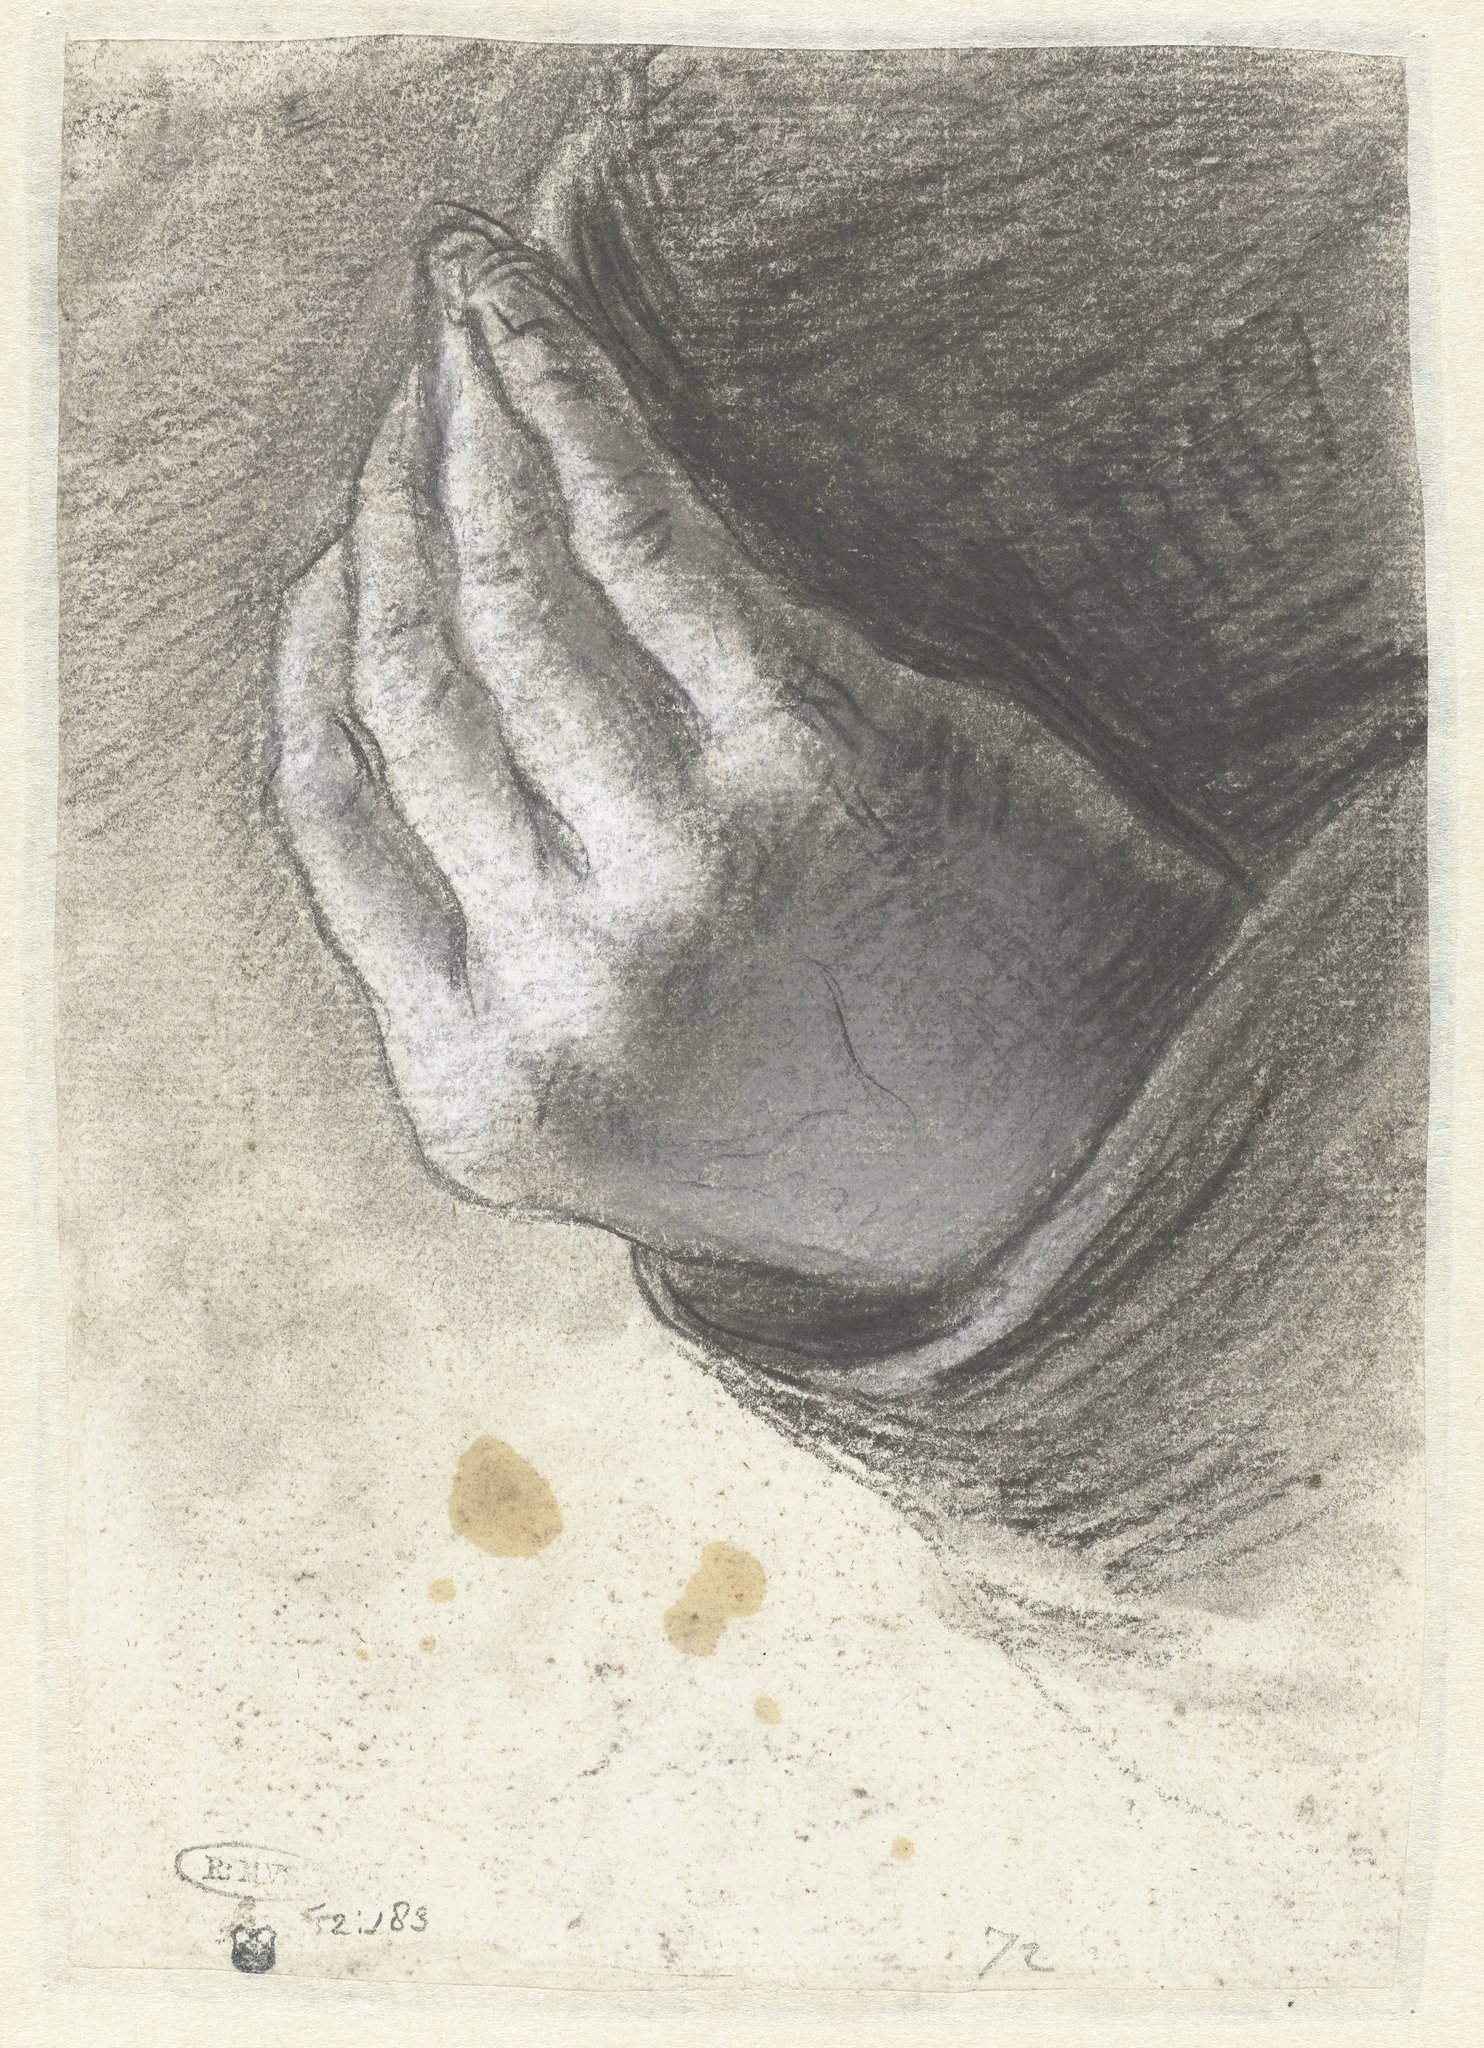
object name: drawing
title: Studie van een hand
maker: simon andreas krausz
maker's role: draughtsman, print maker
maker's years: 1760-1825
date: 1770-1825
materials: chalk, paper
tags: hand